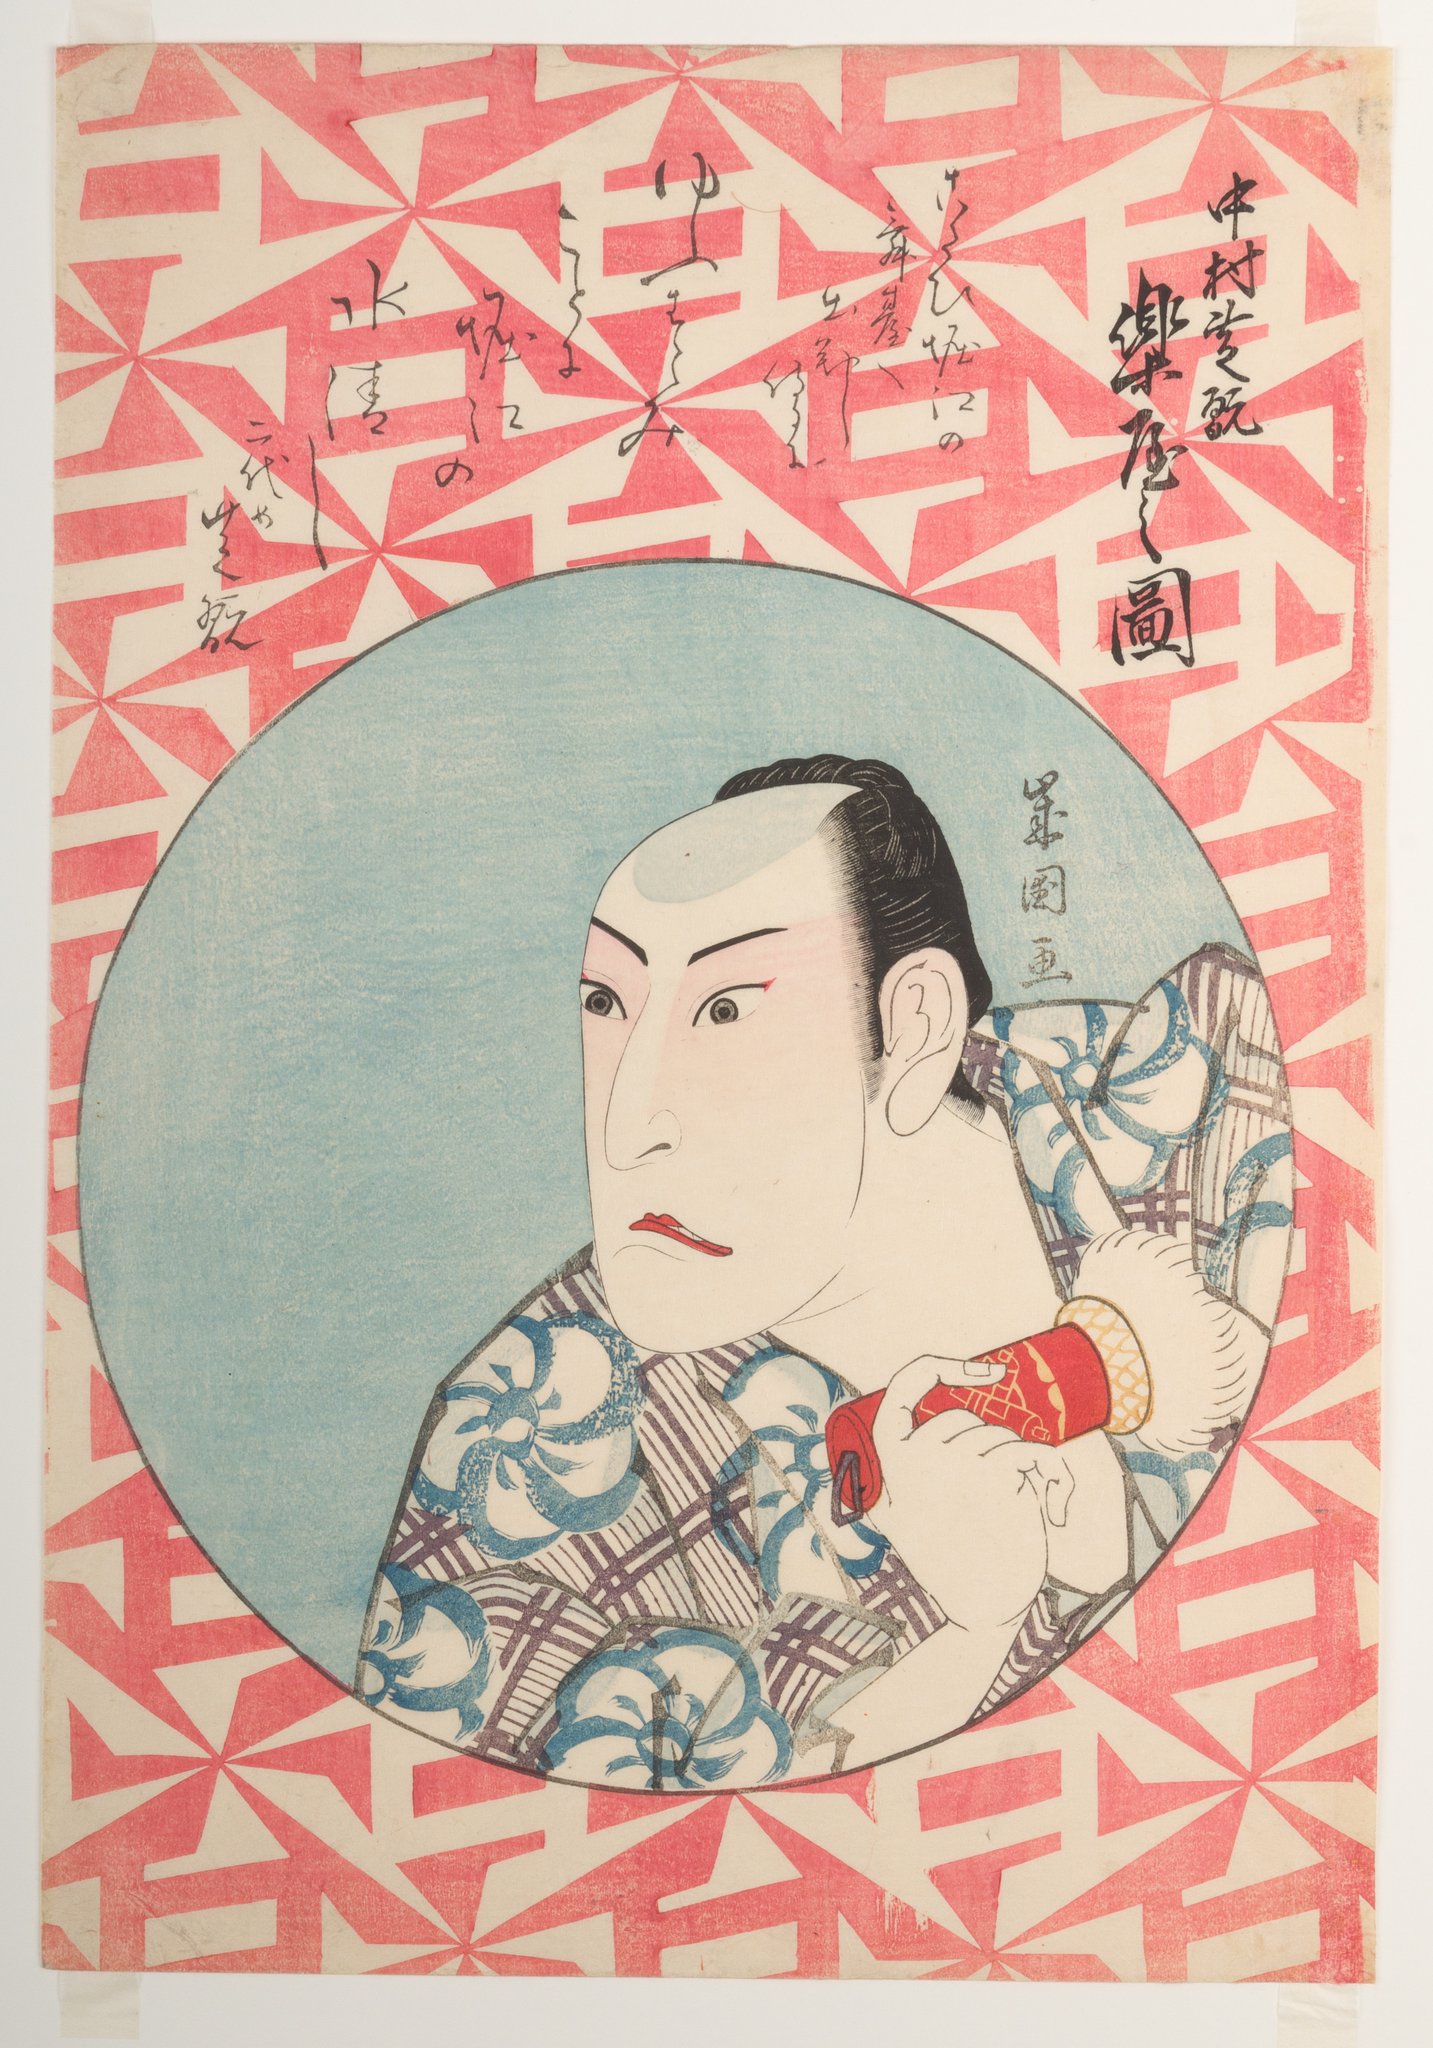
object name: woodblock print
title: Kabuki Actor Nakamura Shikan Backstage (Nakamura Shikan rakuya no zu)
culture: japanese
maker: juyōdō toshikuni 壽陽堂歳国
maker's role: artist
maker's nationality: japanese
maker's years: 1816-1830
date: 1826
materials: ink, paper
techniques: woodblock print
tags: men,actors